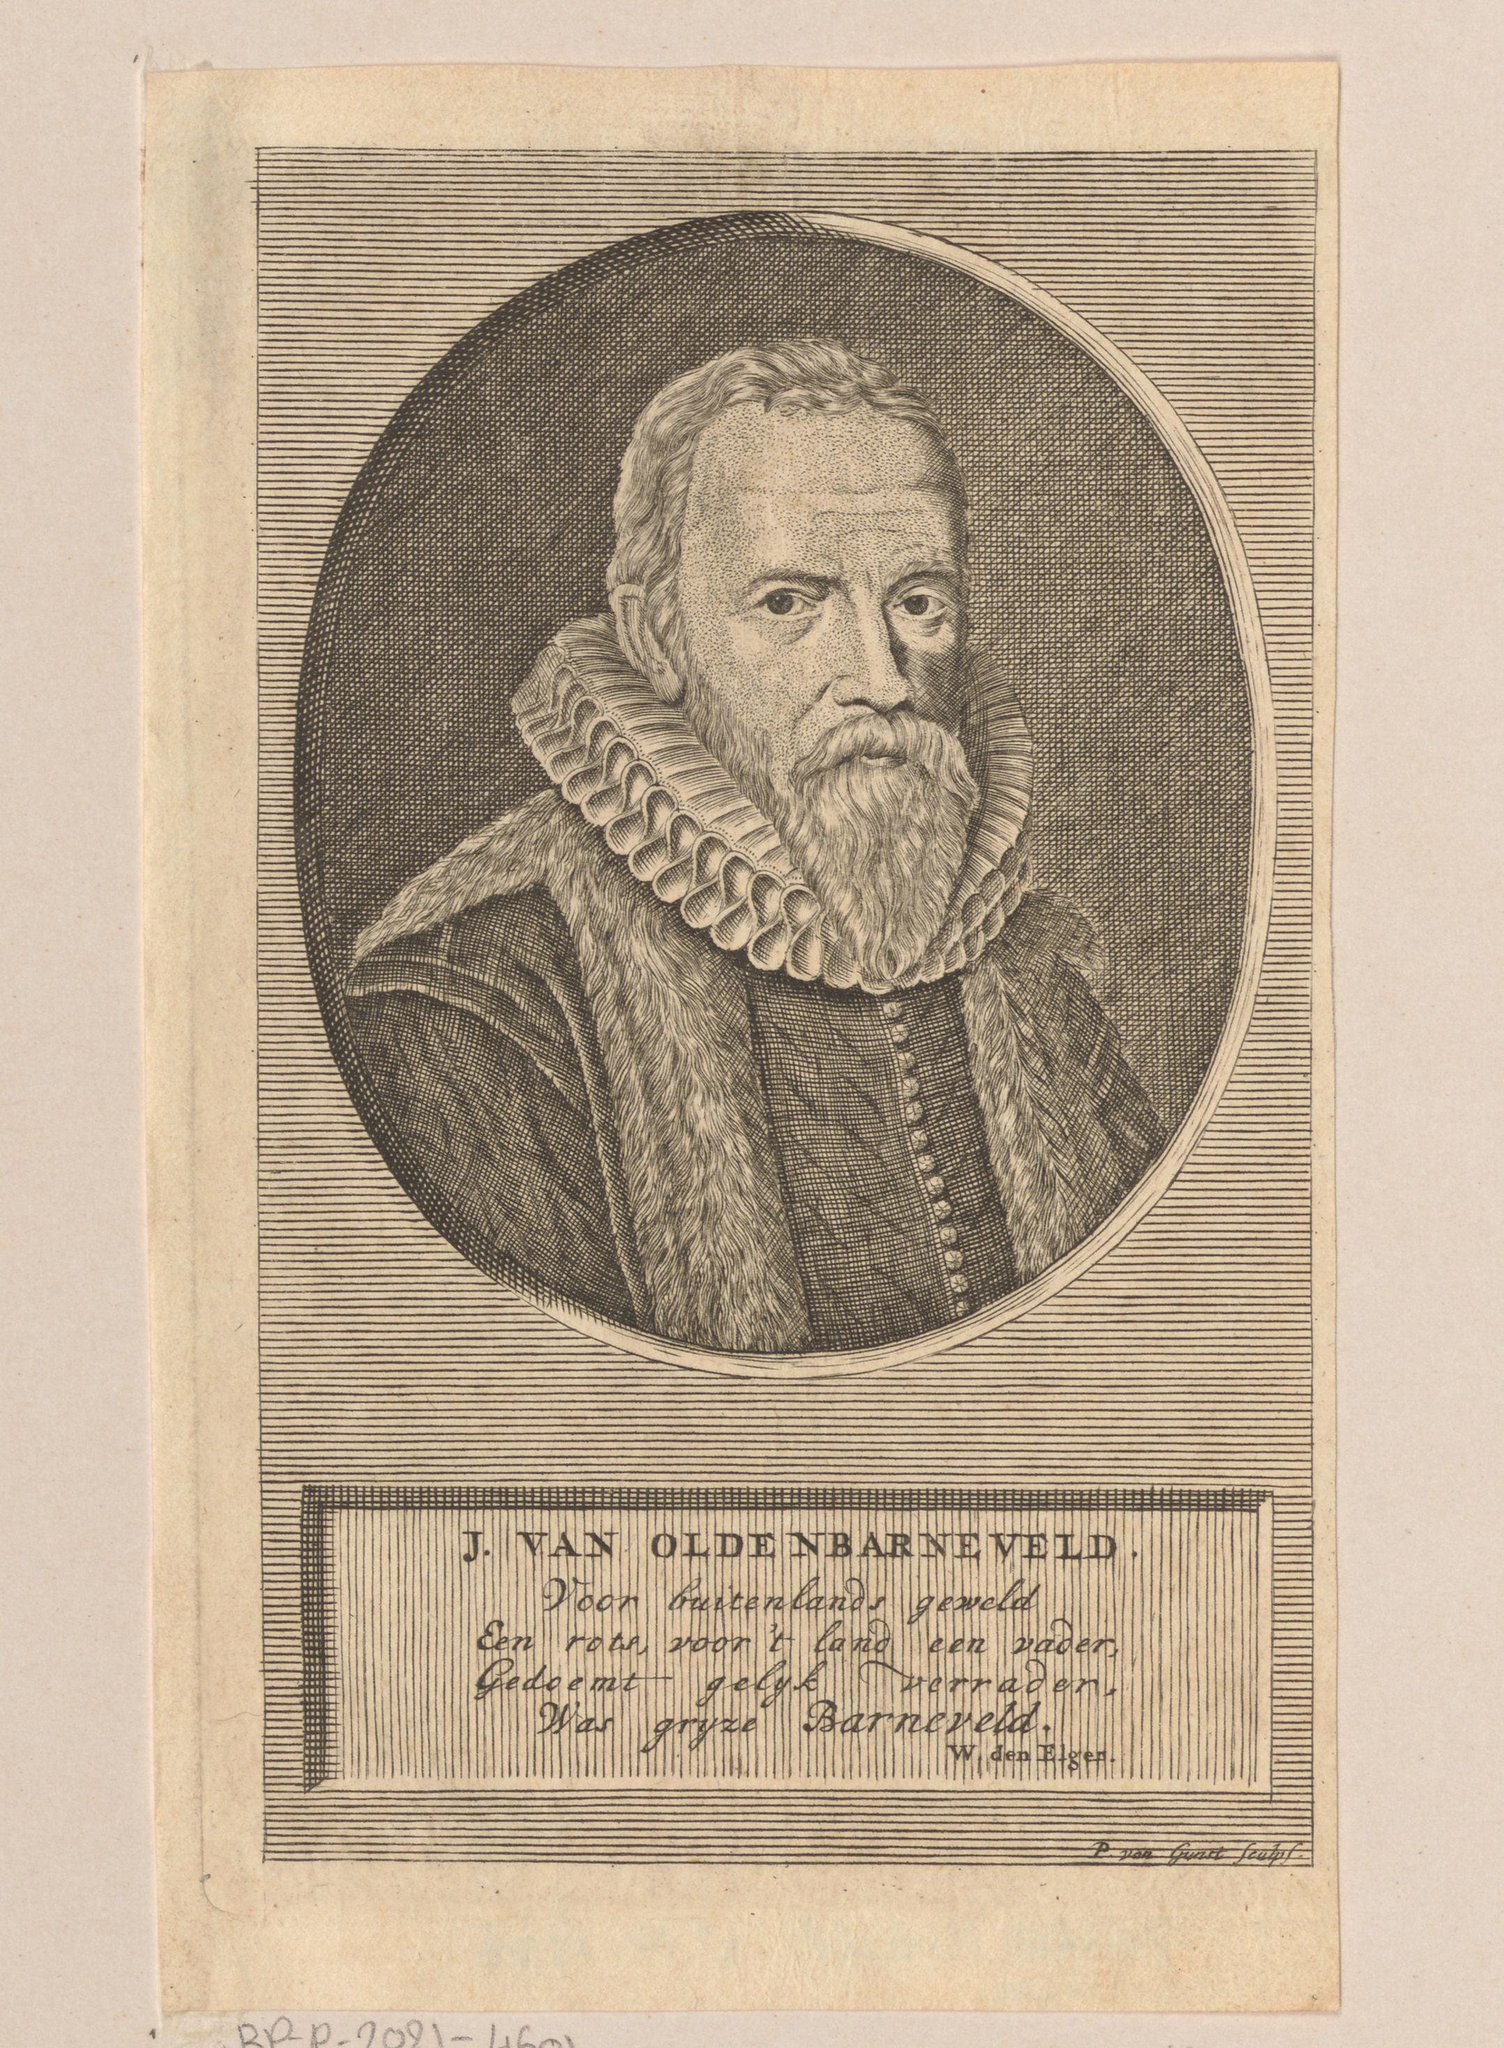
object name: print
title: Portret van Johan van Oldenbarnevelt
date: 1669-1736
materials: paper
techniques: engraving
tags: the hague, johan van oldenbarnevelt, historical persons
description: Prent mogelijk uit: J. v. Vondels Hekeldichten (...). Amersfoort: Pieter Brakman, 1736, dl. 1.